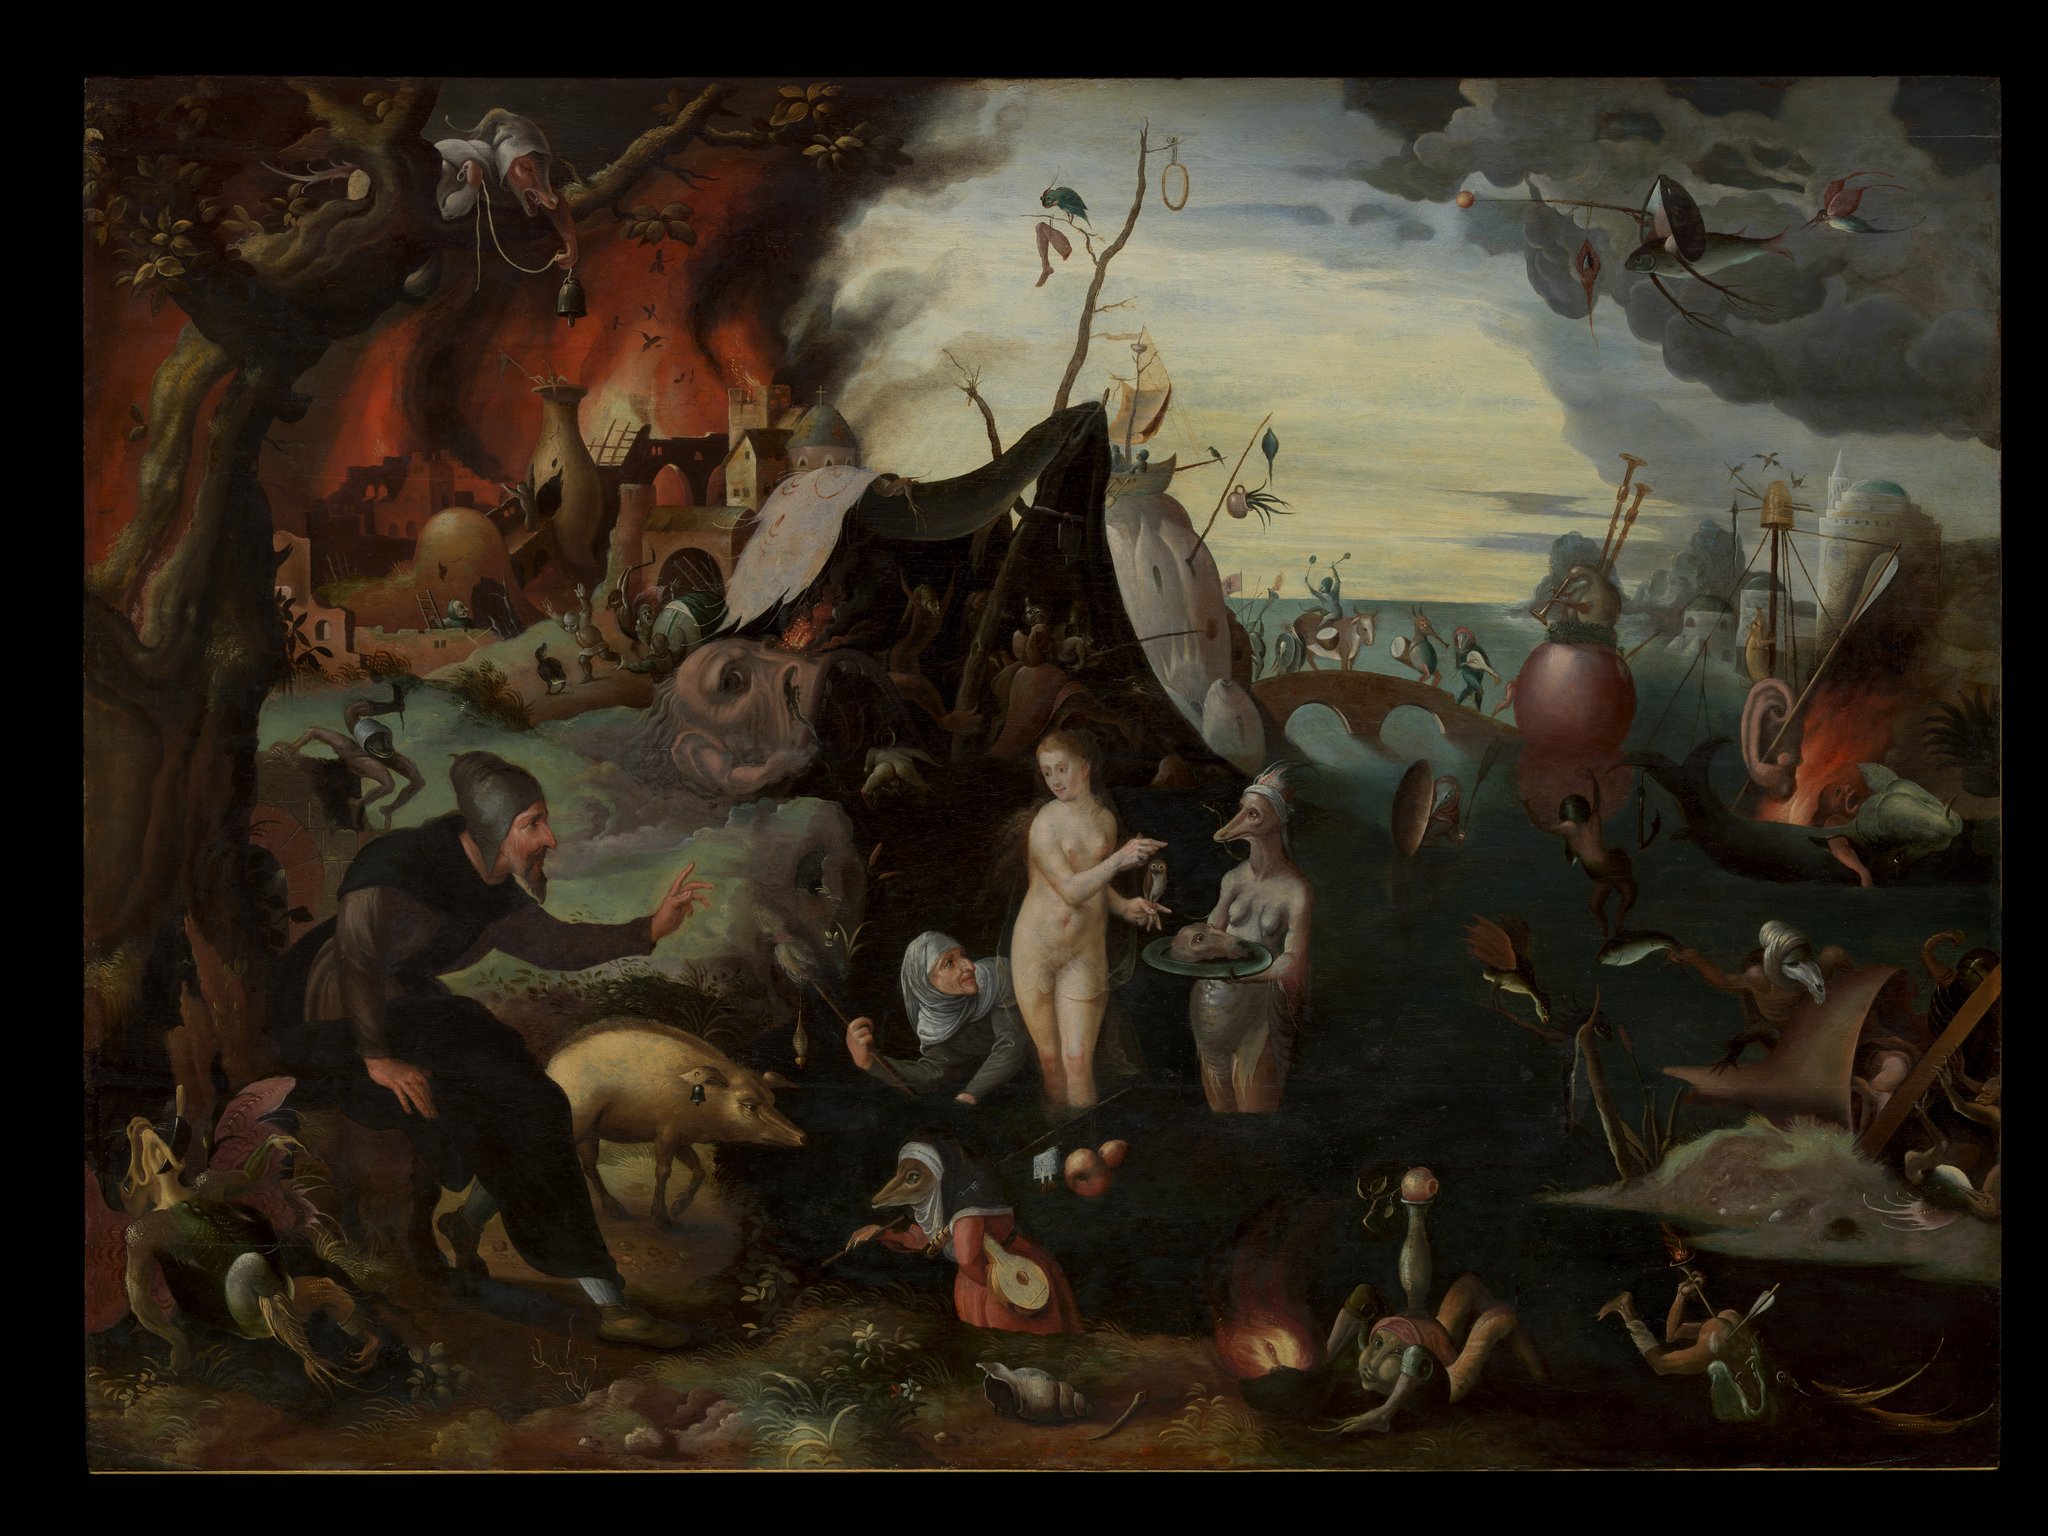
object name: painting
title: The Temptation of Saint Anthony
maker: pieter huys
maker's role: artist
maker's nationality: netherlandish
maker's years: 1545-1584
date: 1545-1584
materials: wood, oil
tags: birds,female nudes,mythical creatures,pigs,saint anthony